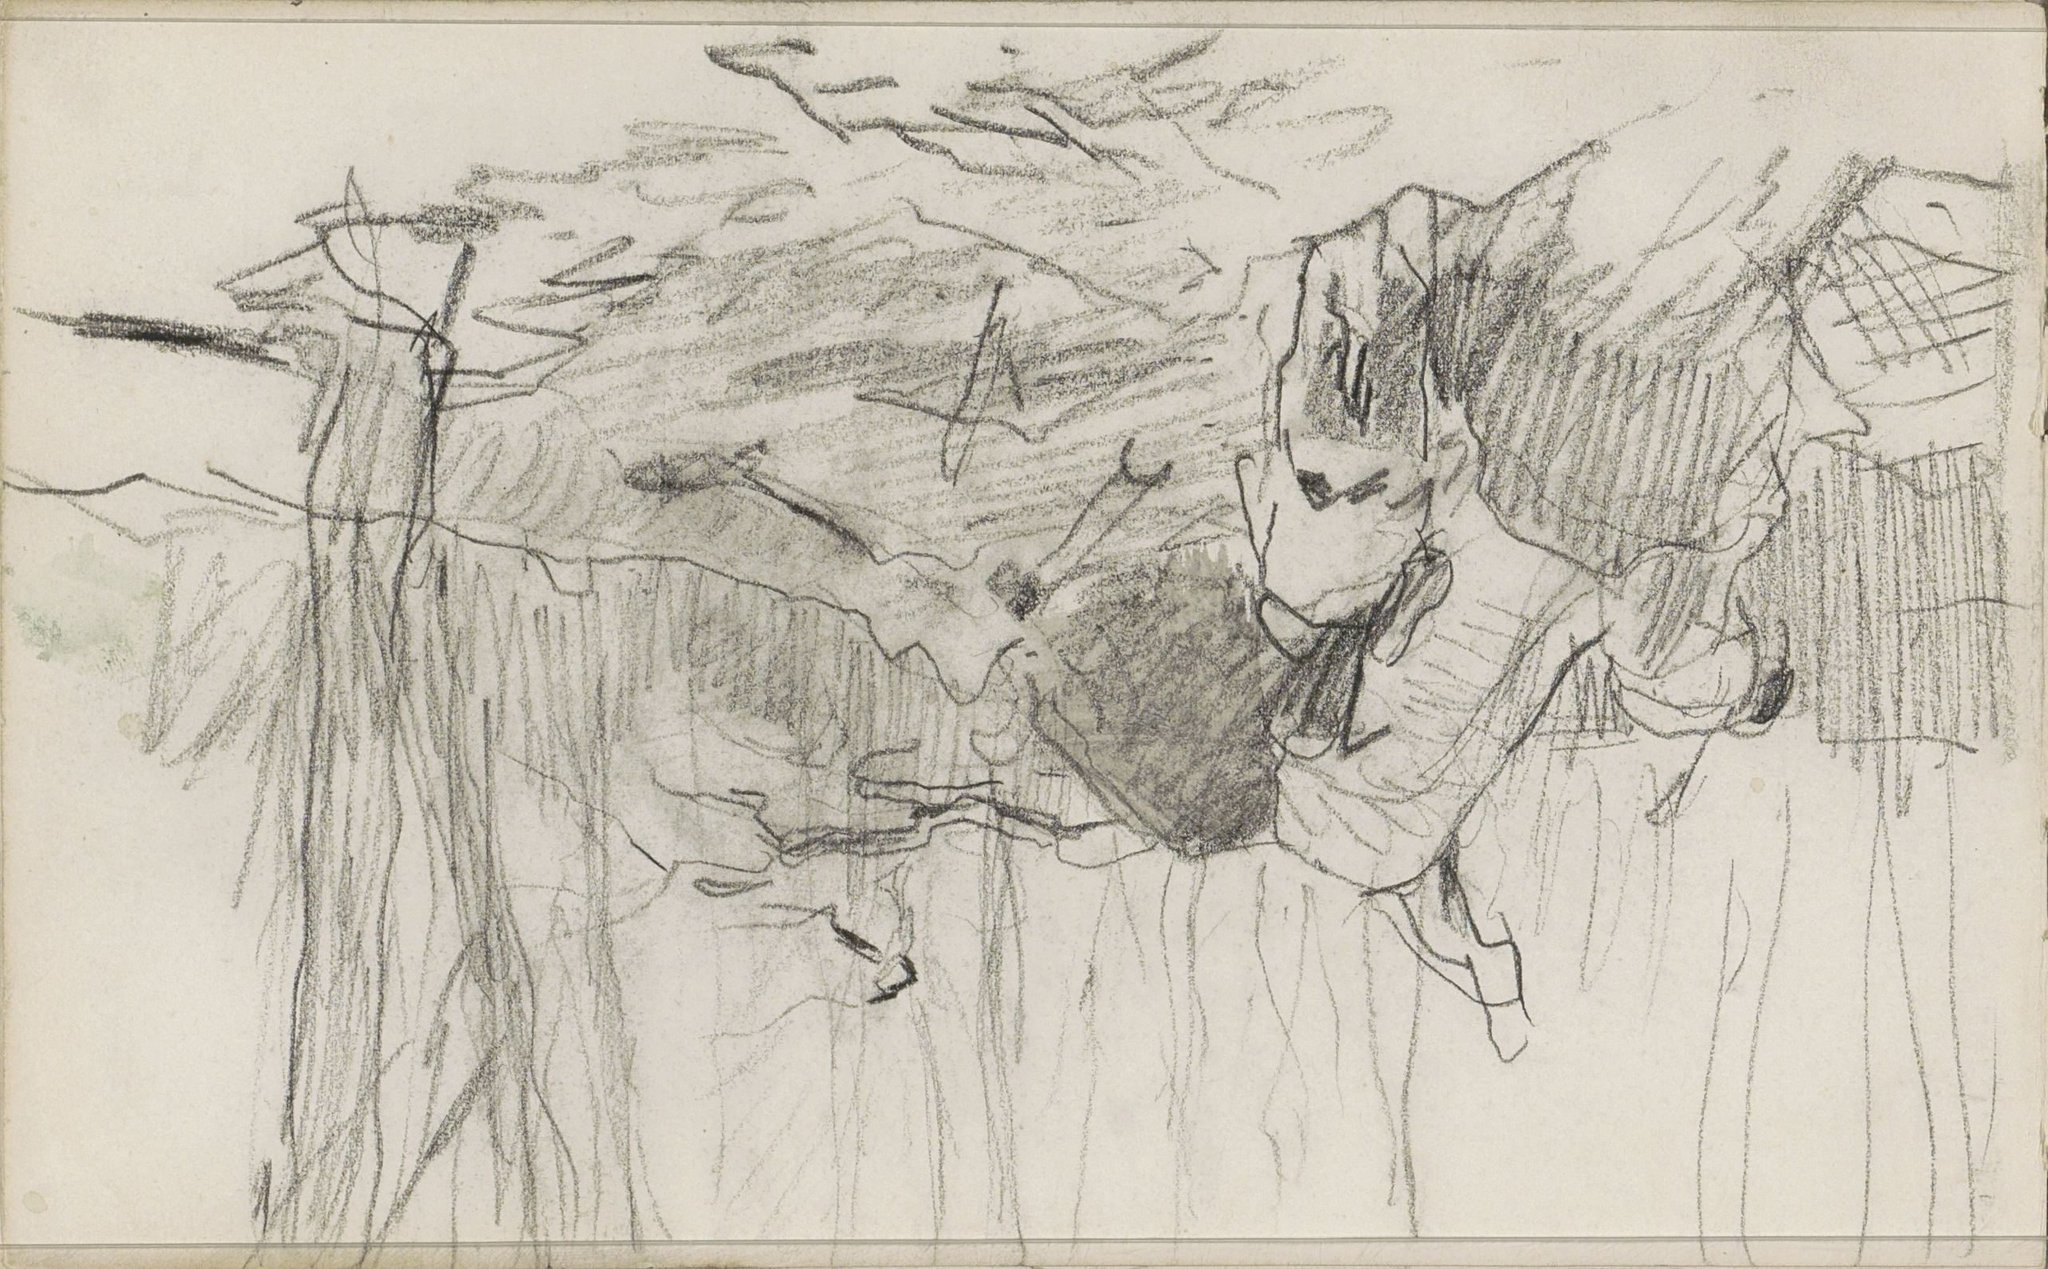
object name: sketchbook leaf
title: Houthakkers bij een omgehakte boom in een bos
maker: anton mauve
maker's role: draughtsman, painter, print maker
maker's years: 1838-1888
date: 1848-1888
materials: chalk, paper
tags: woodcutting, woodcutter ~ forestry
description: Blad 6 verso uit een schetsboek met 41 bladen.